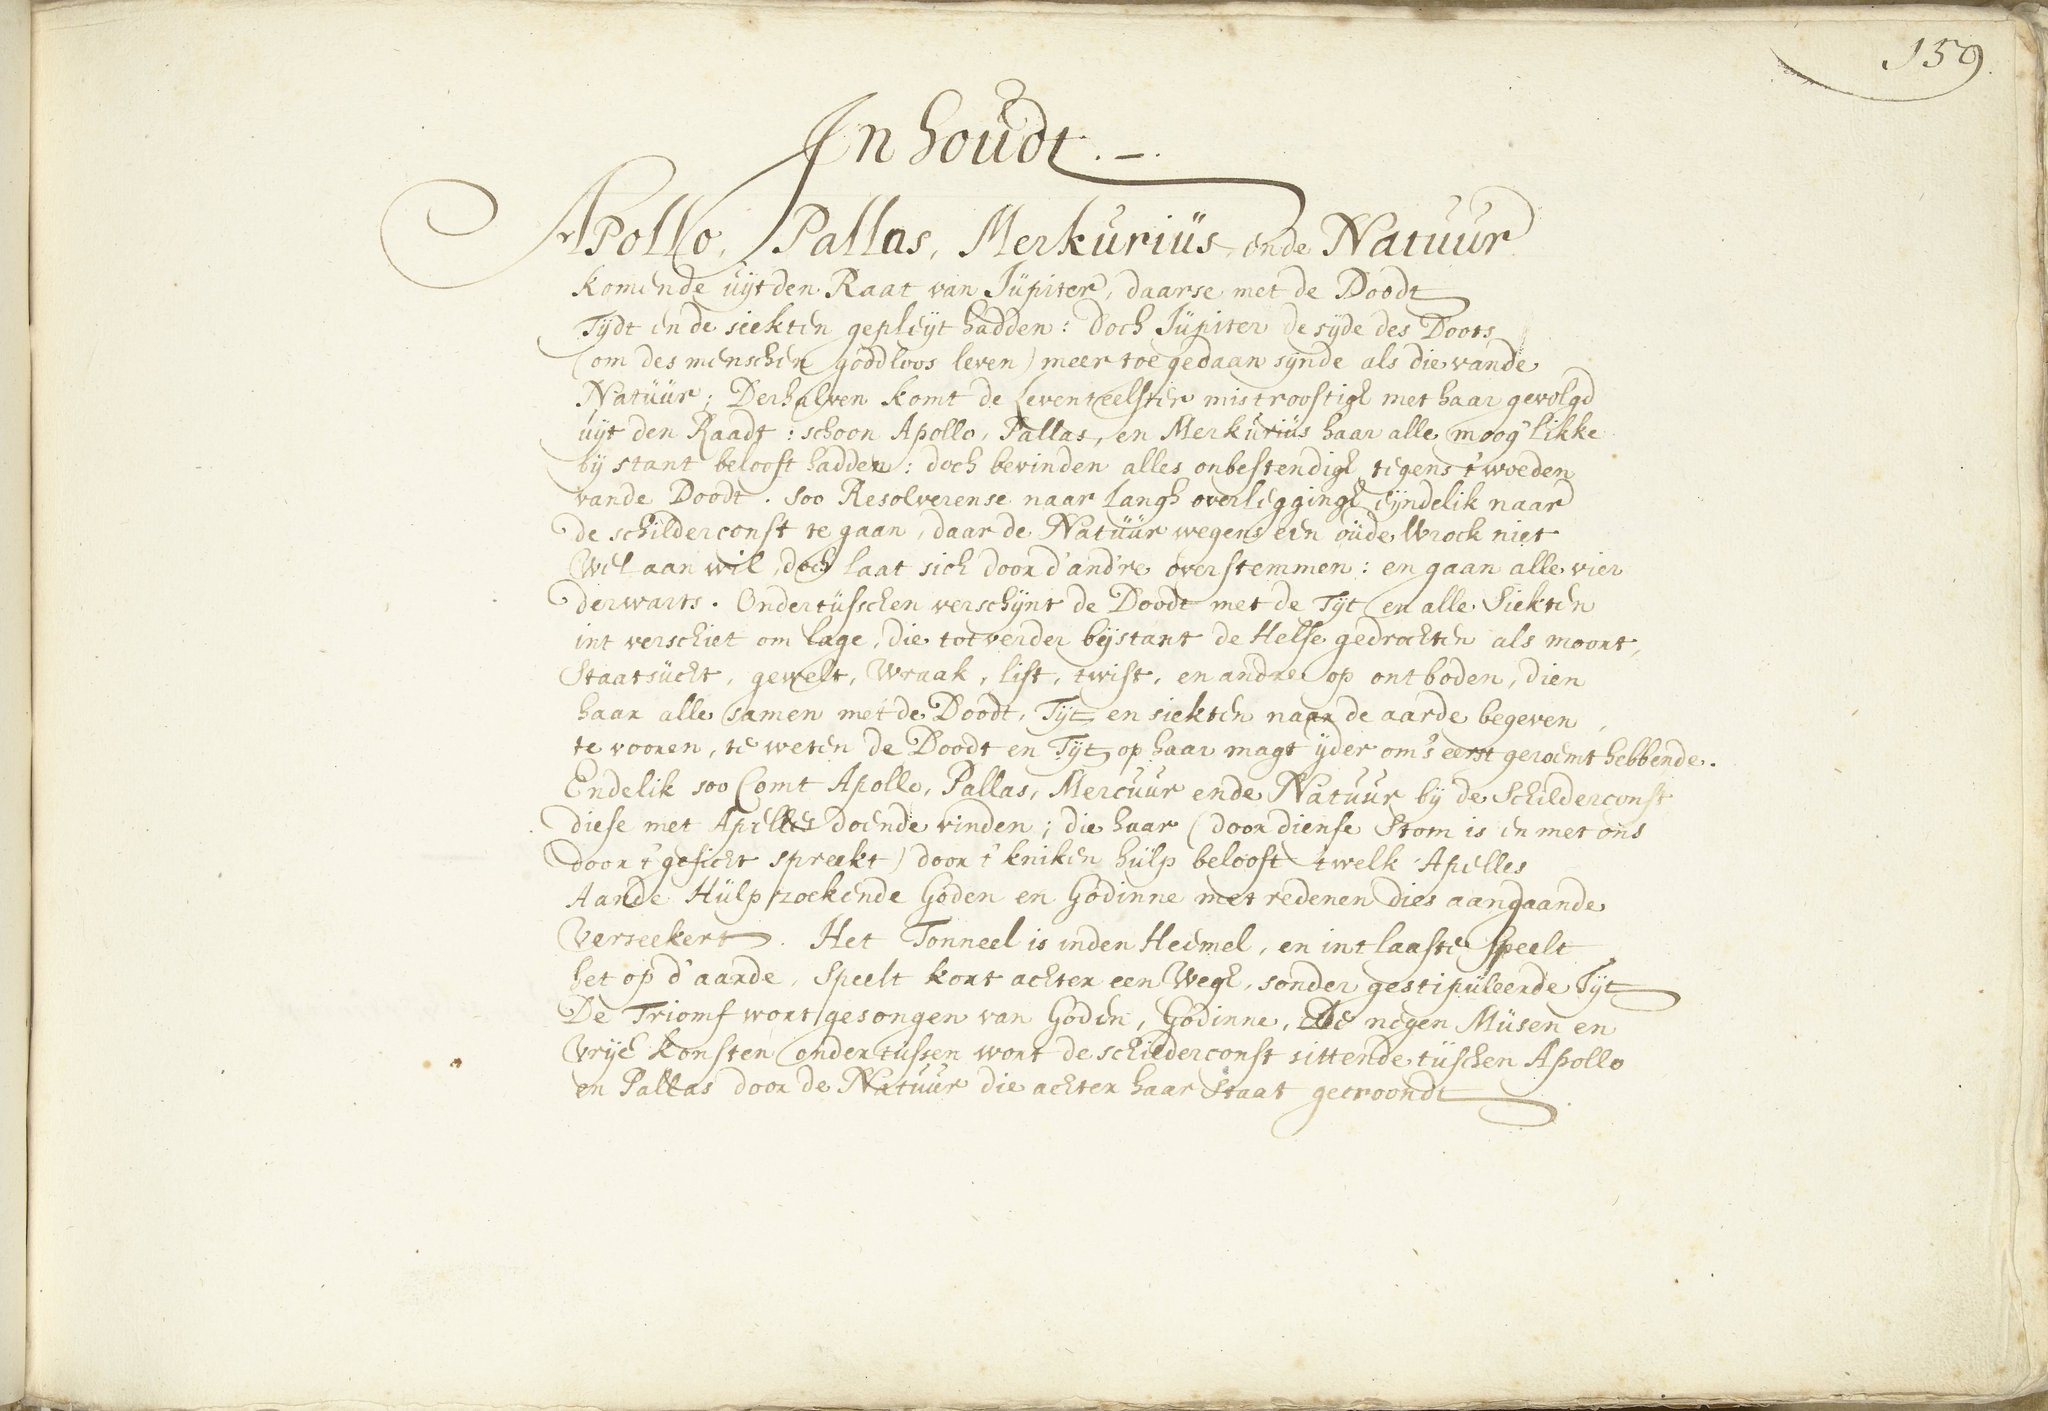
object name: text sheet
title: Inhoudt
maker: henrik jordis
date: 1660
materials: ink, paper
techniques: writing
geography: zwolle